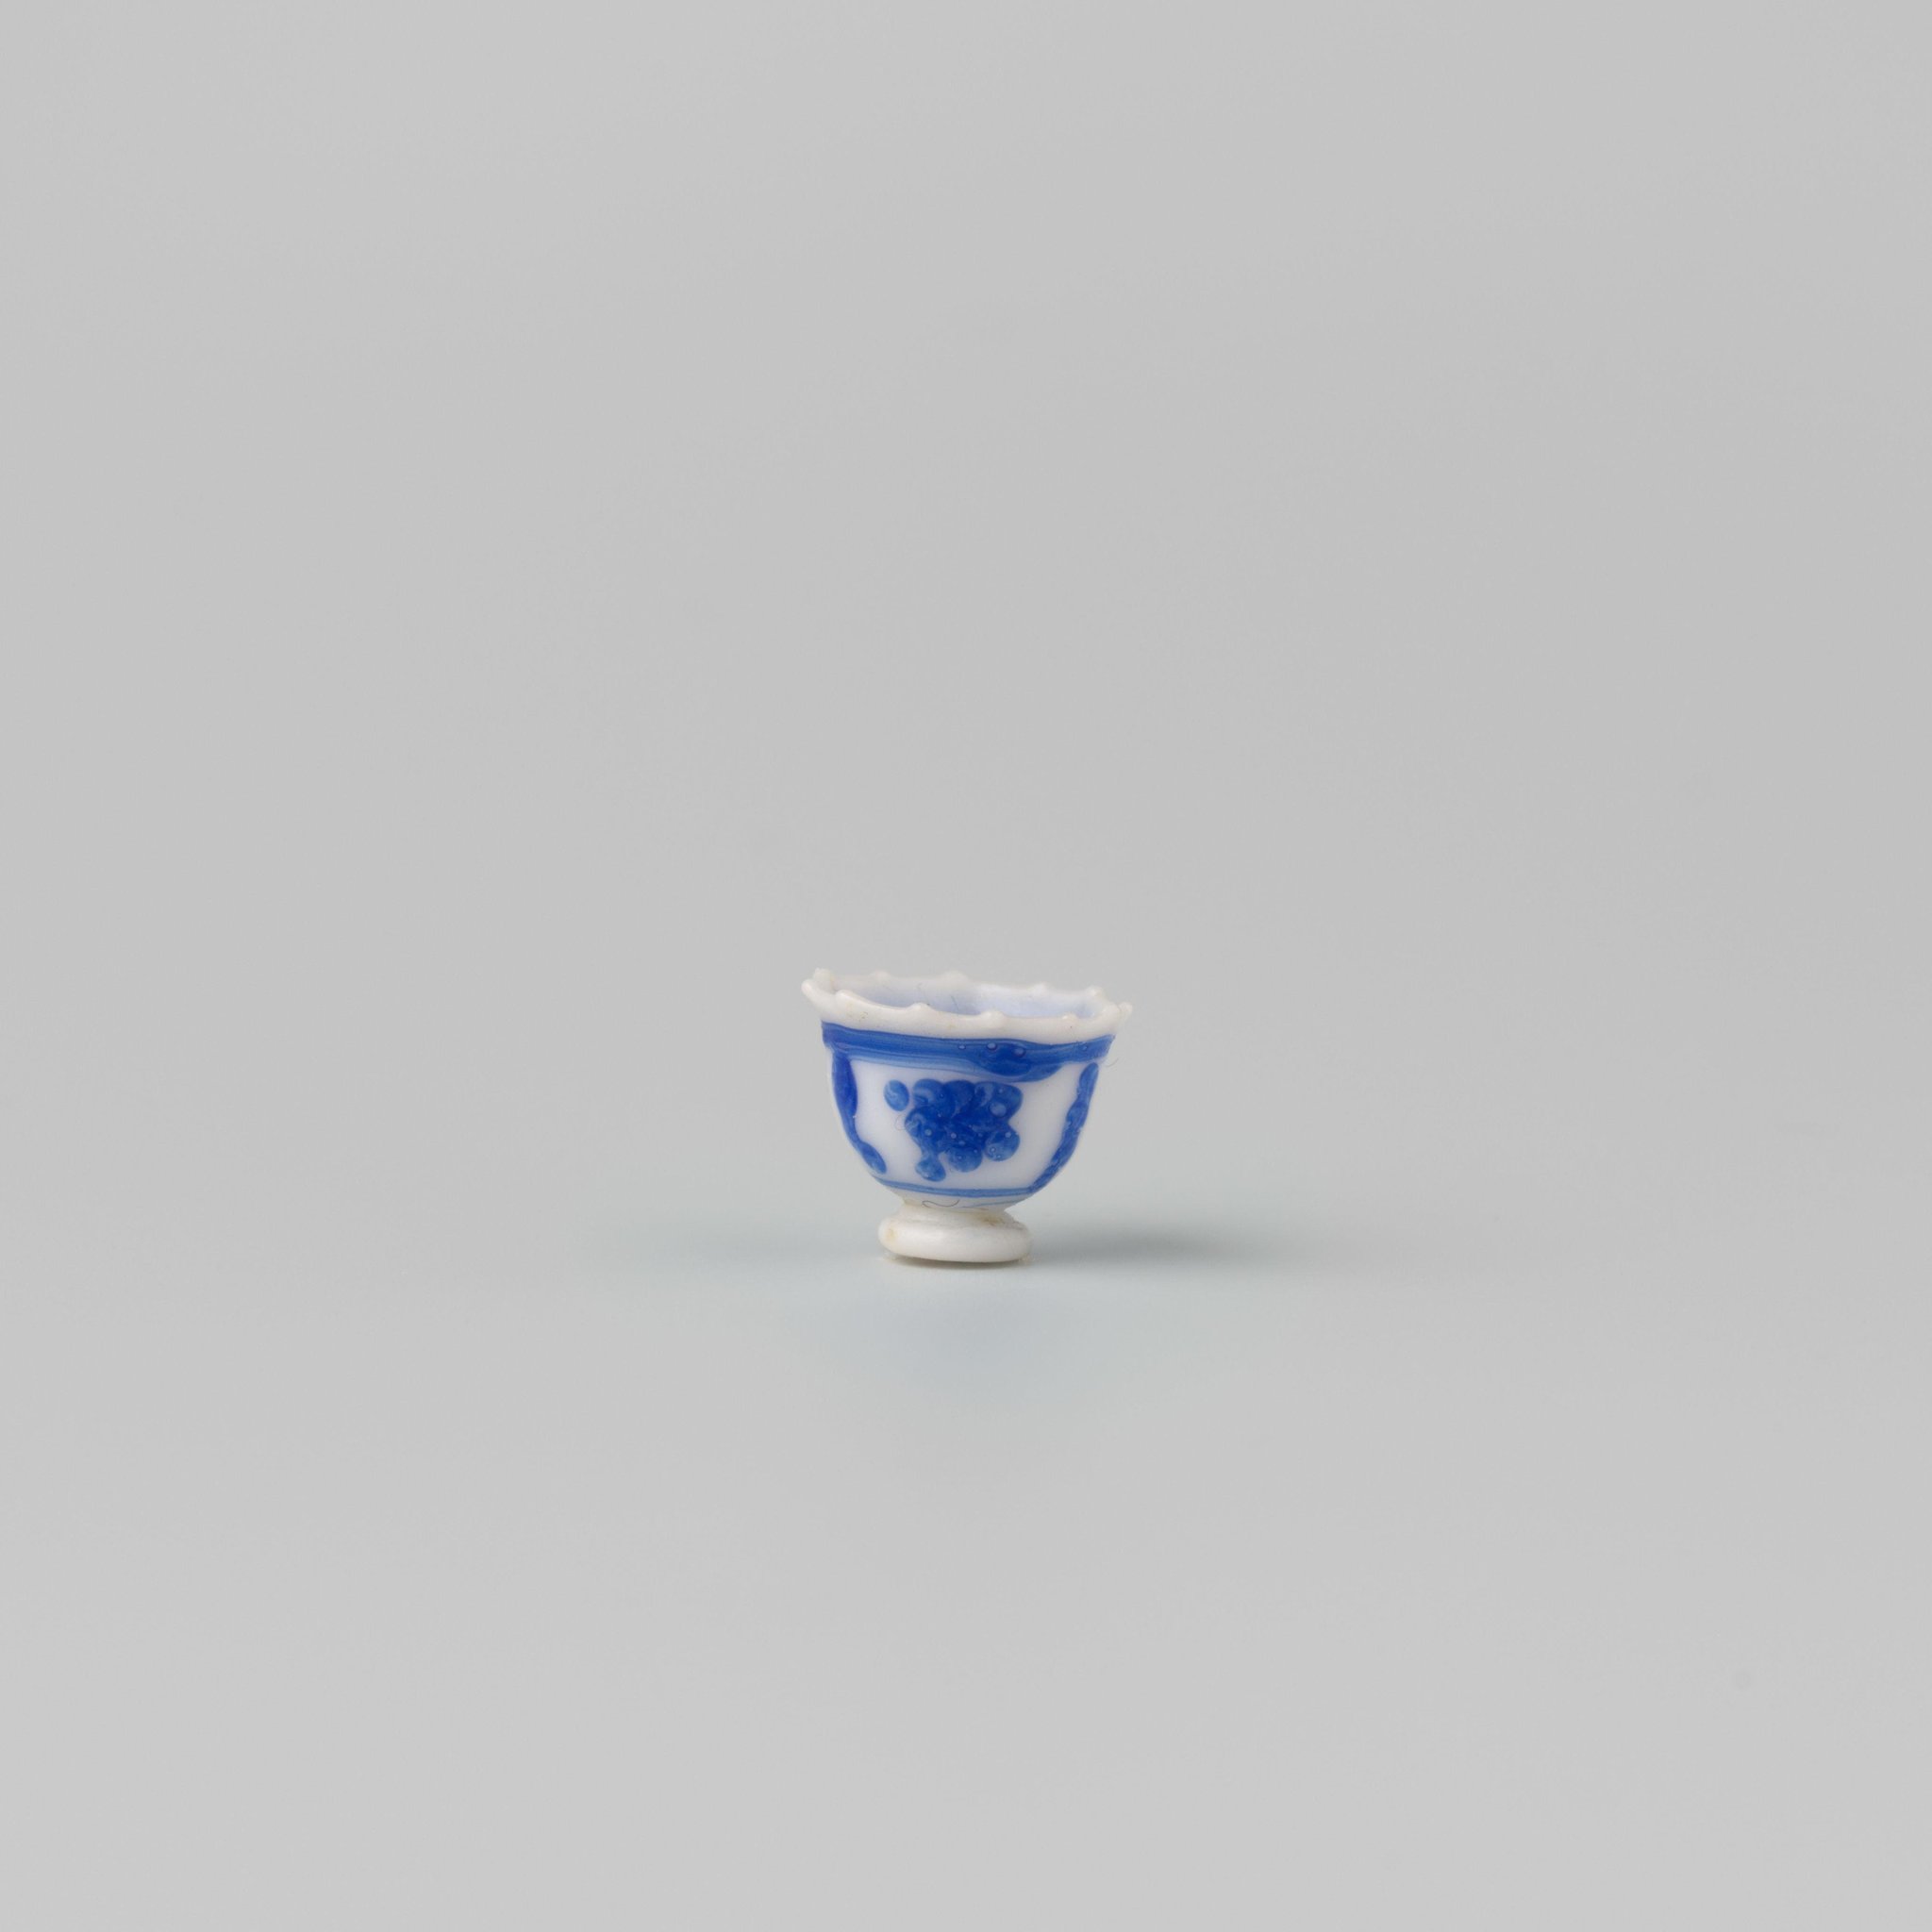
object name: miniature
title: Theekopje van melkglas met blauwe emailverf beschildering, imitatie Chinees porselein met 'bloem' decoratie in vakken; model op los aangebrachte standring en met puntrand.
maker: Anonymous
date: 1675-1710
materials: glass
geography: amsterdam